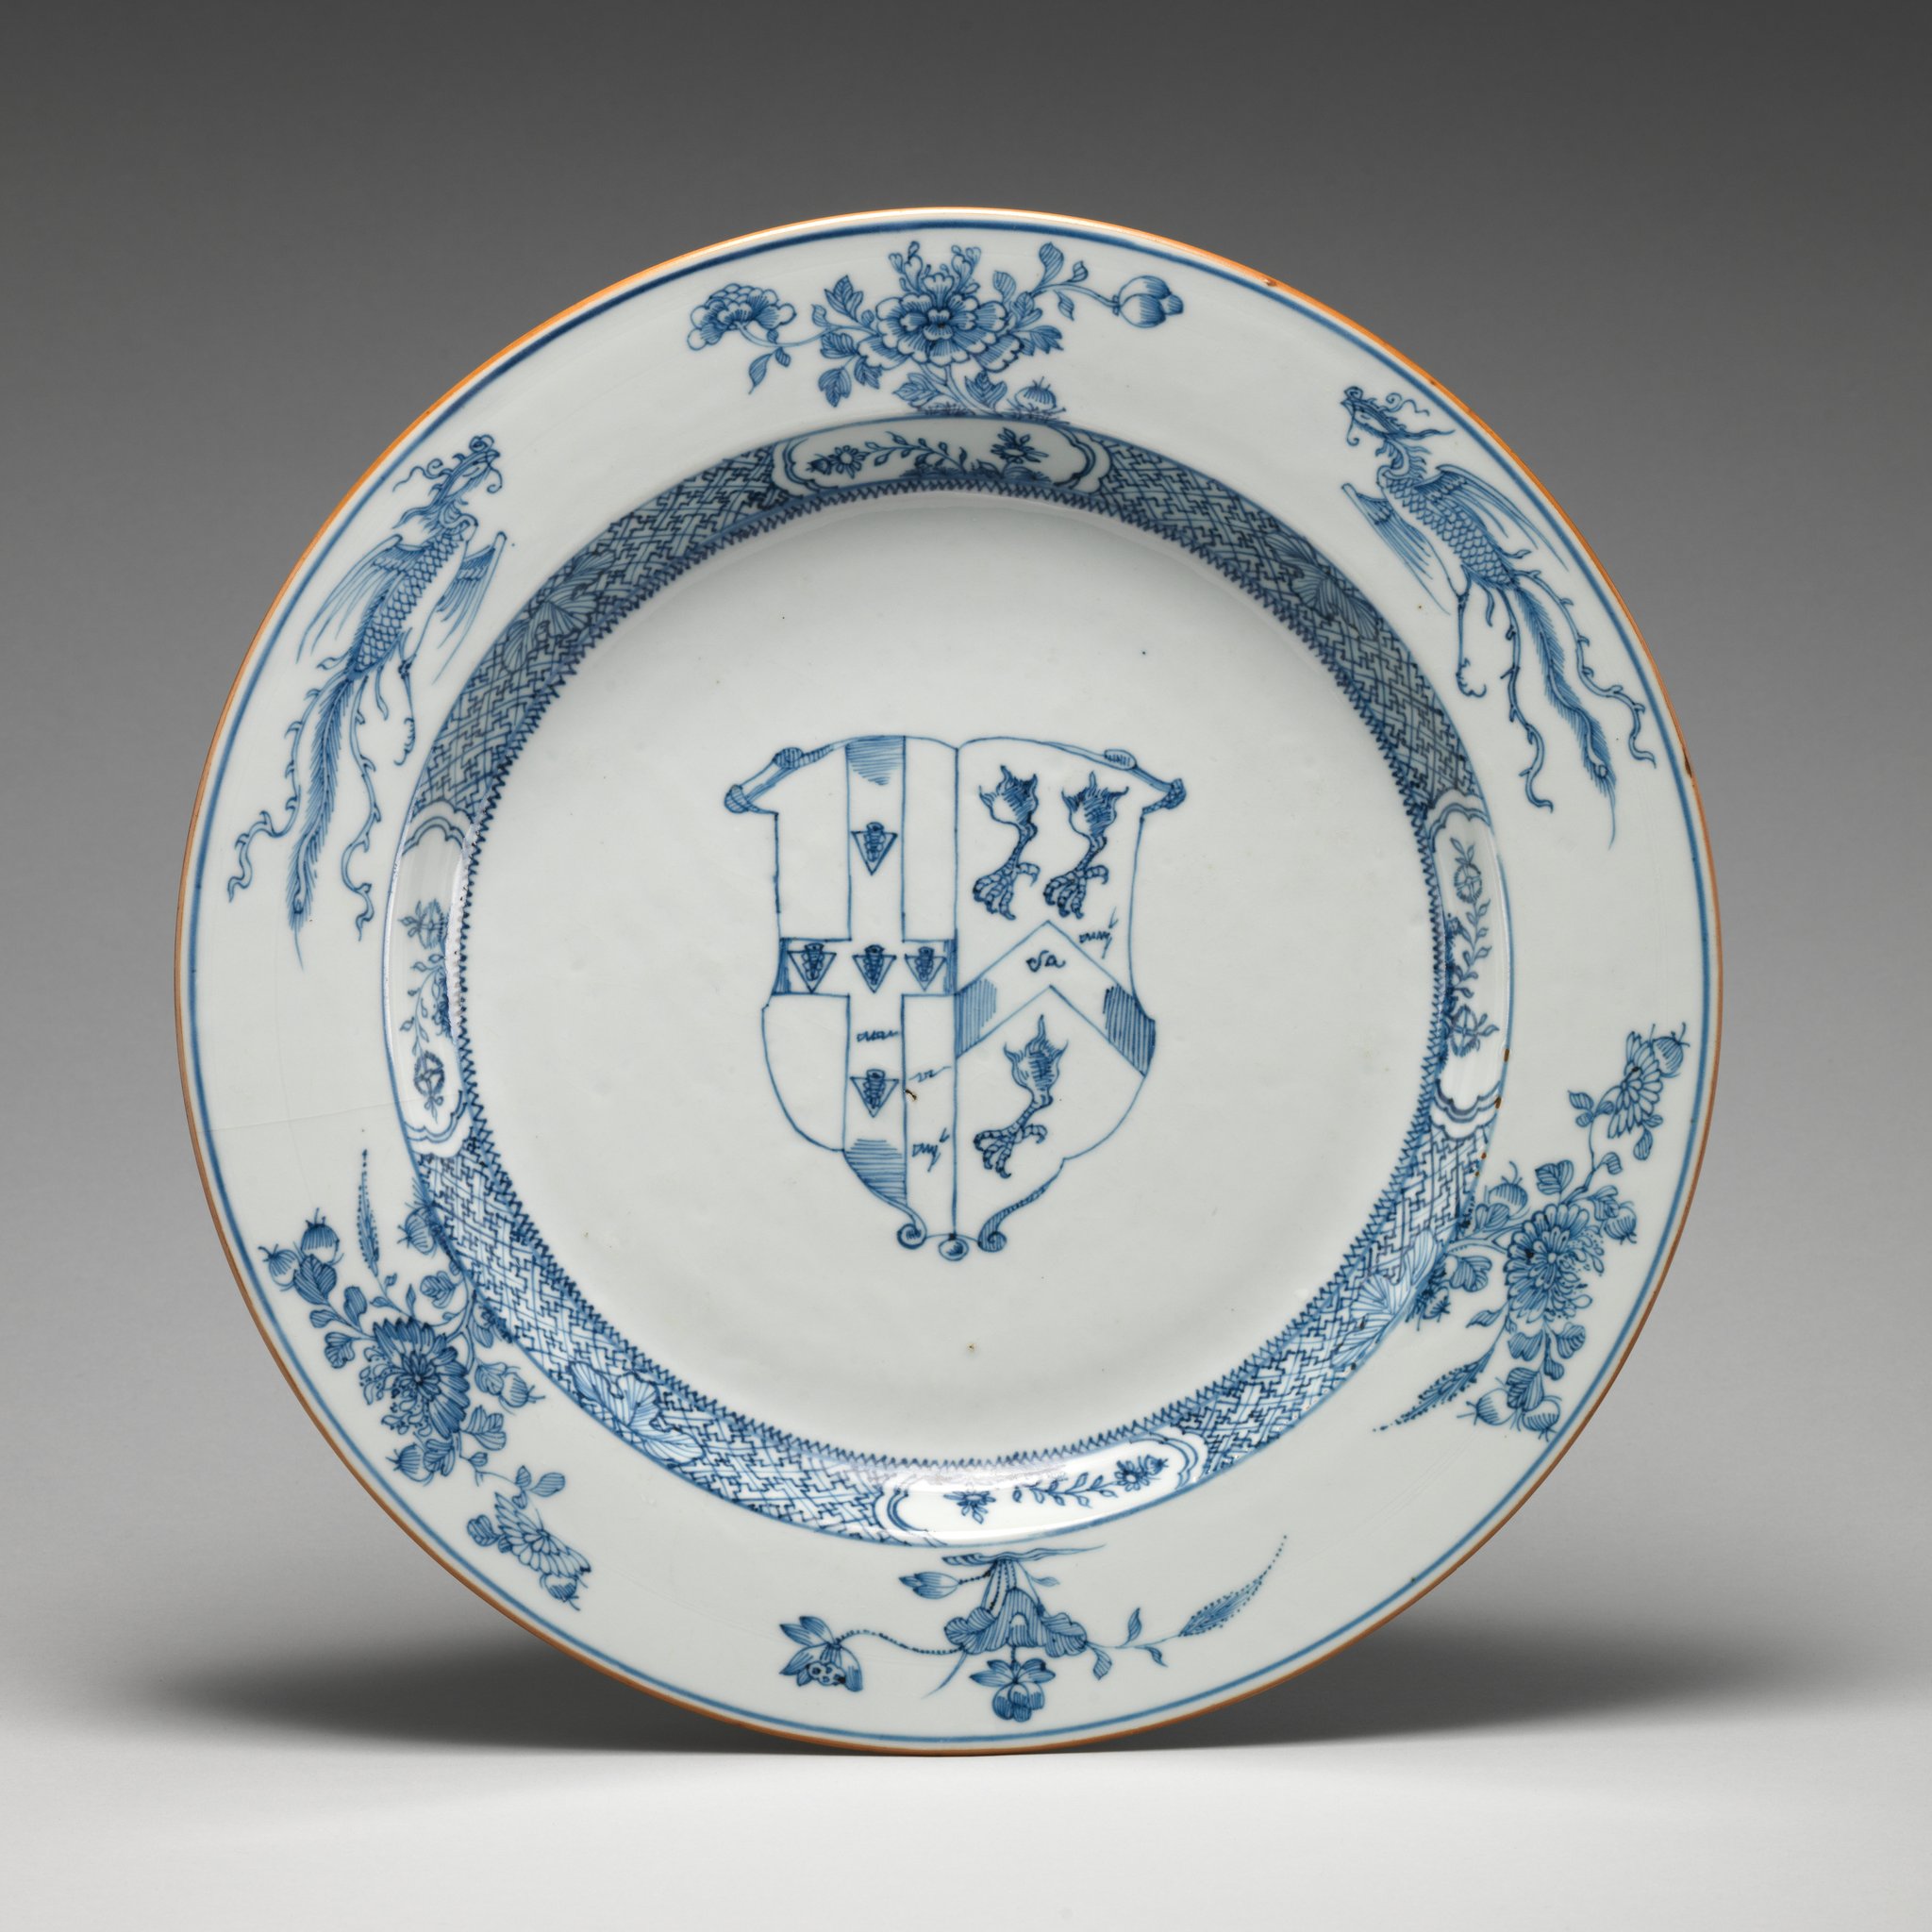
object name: dish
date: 1720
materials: hard paste porcelain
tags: flowers,coat of arms